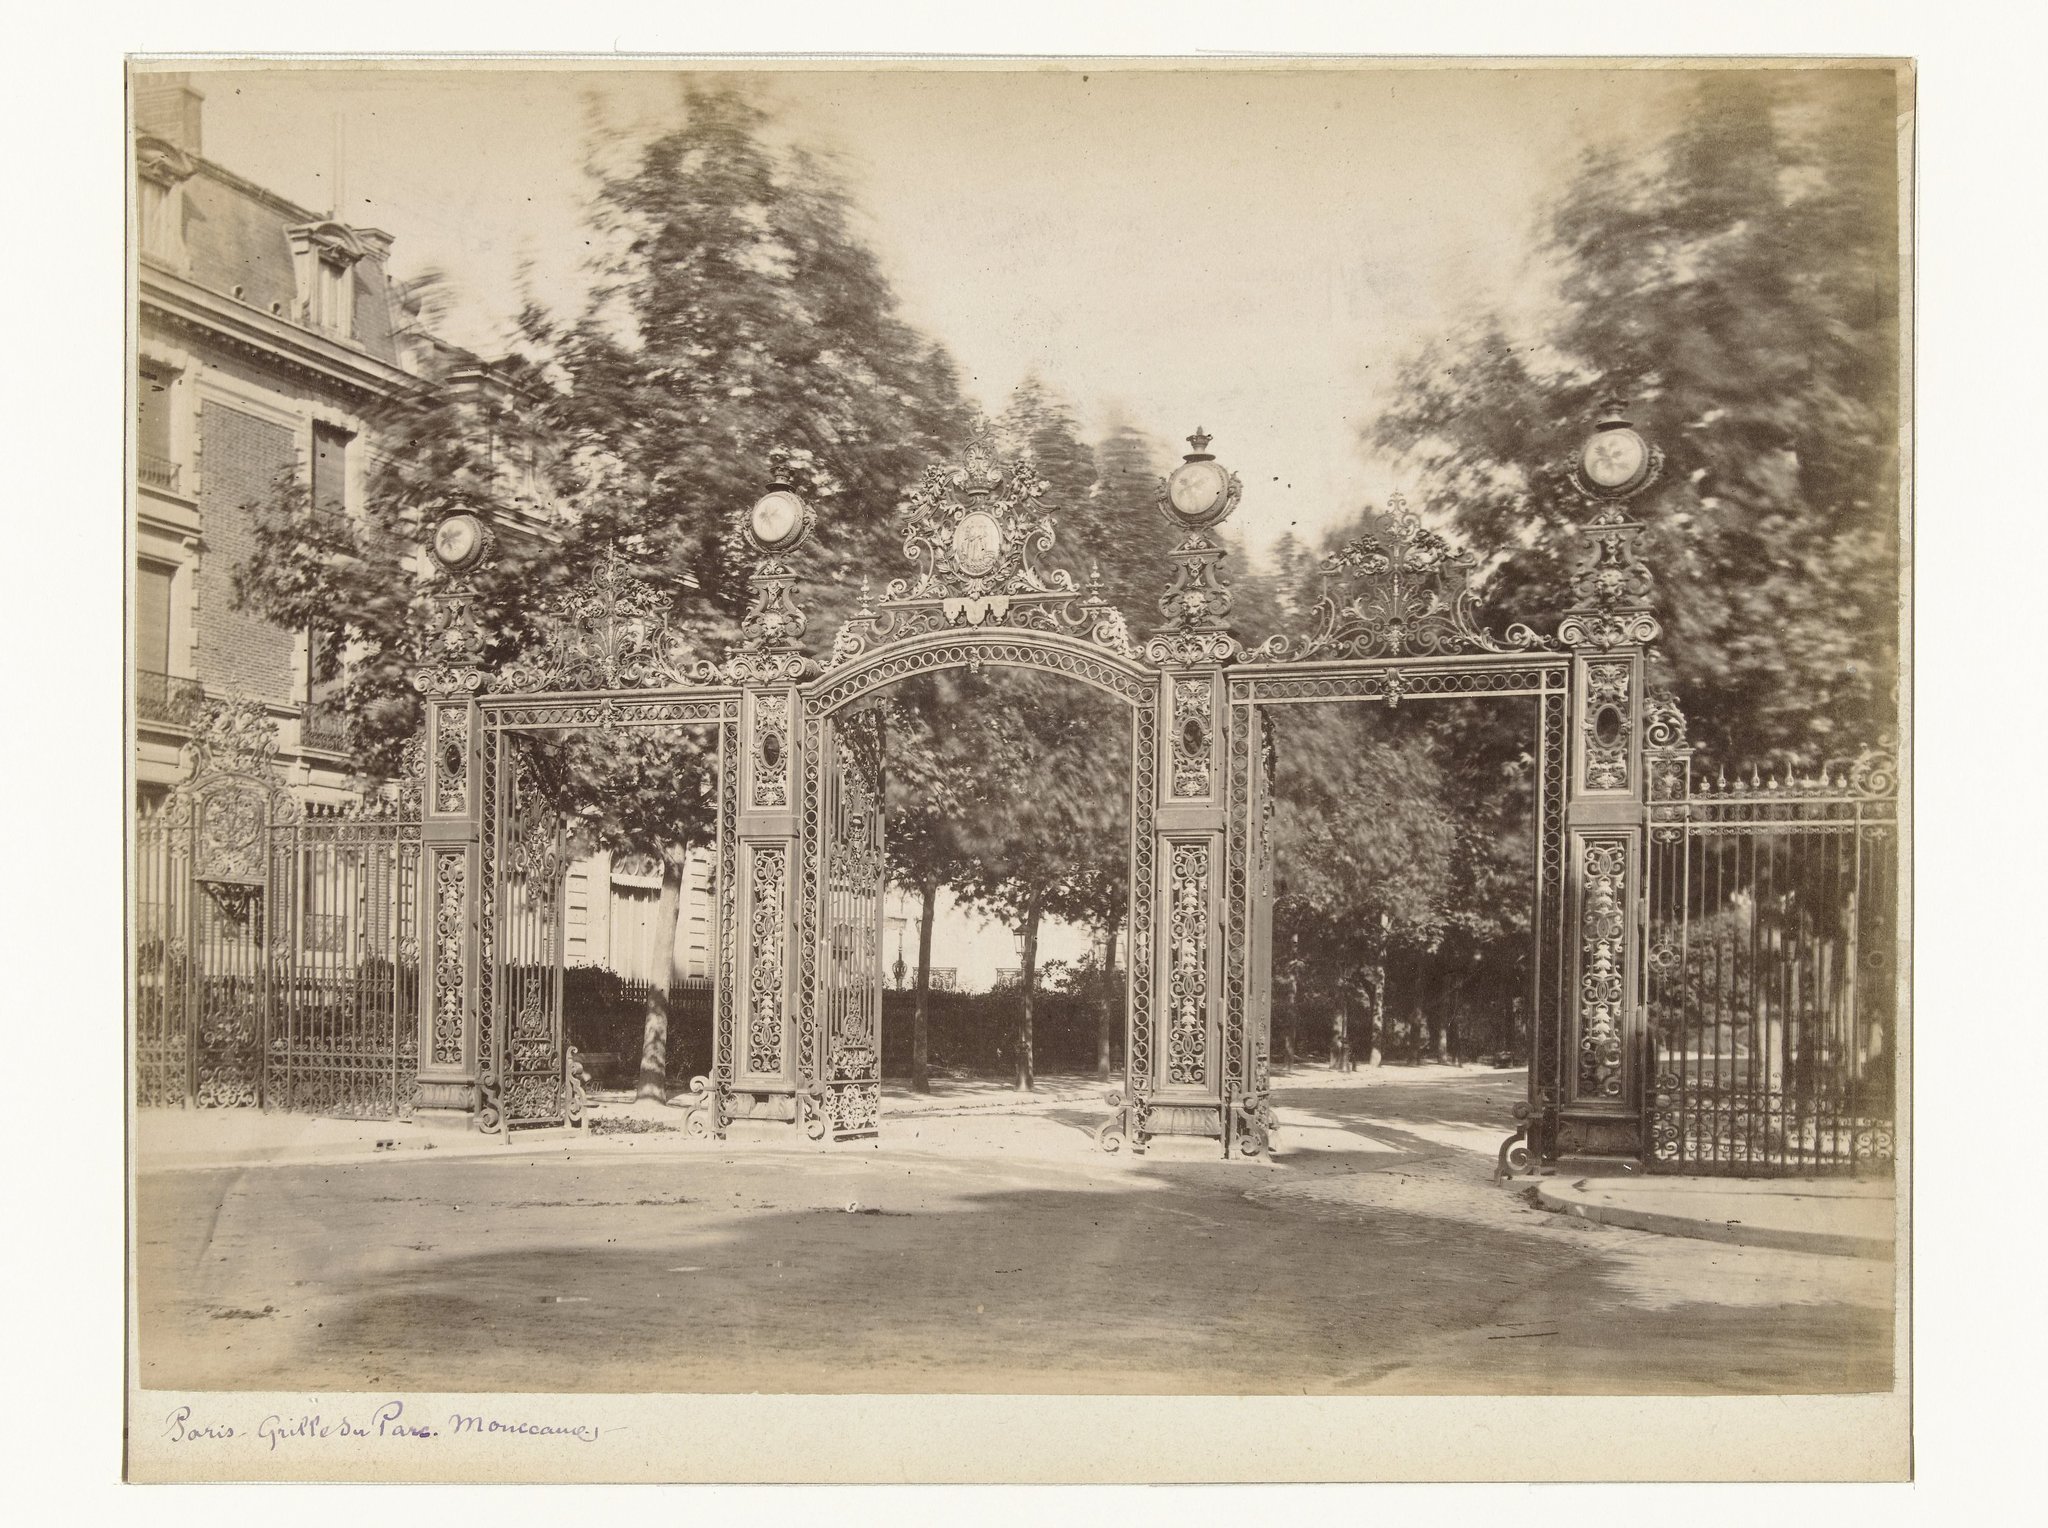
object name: photograph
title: Entrée van Parc Monceau in Parijs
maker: Anonymous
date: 1870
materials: cardboard, paper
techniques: albumen print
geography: paris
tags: gate, entrance, public gardens, park